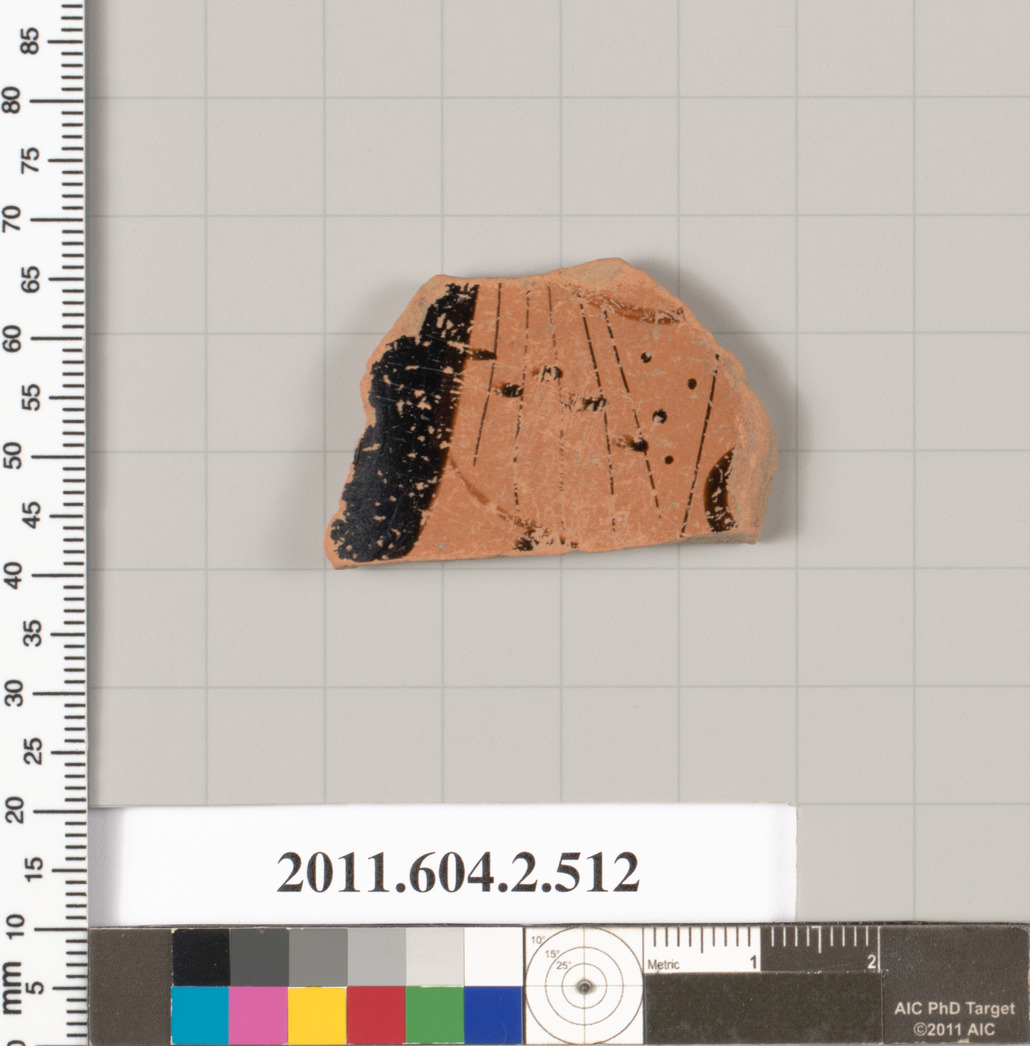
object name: column krater fragment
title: Terracotta fragment of a column-krater (bowl for mixing wine and water)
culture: greek, attic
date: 460-440 BCE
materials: terracotta